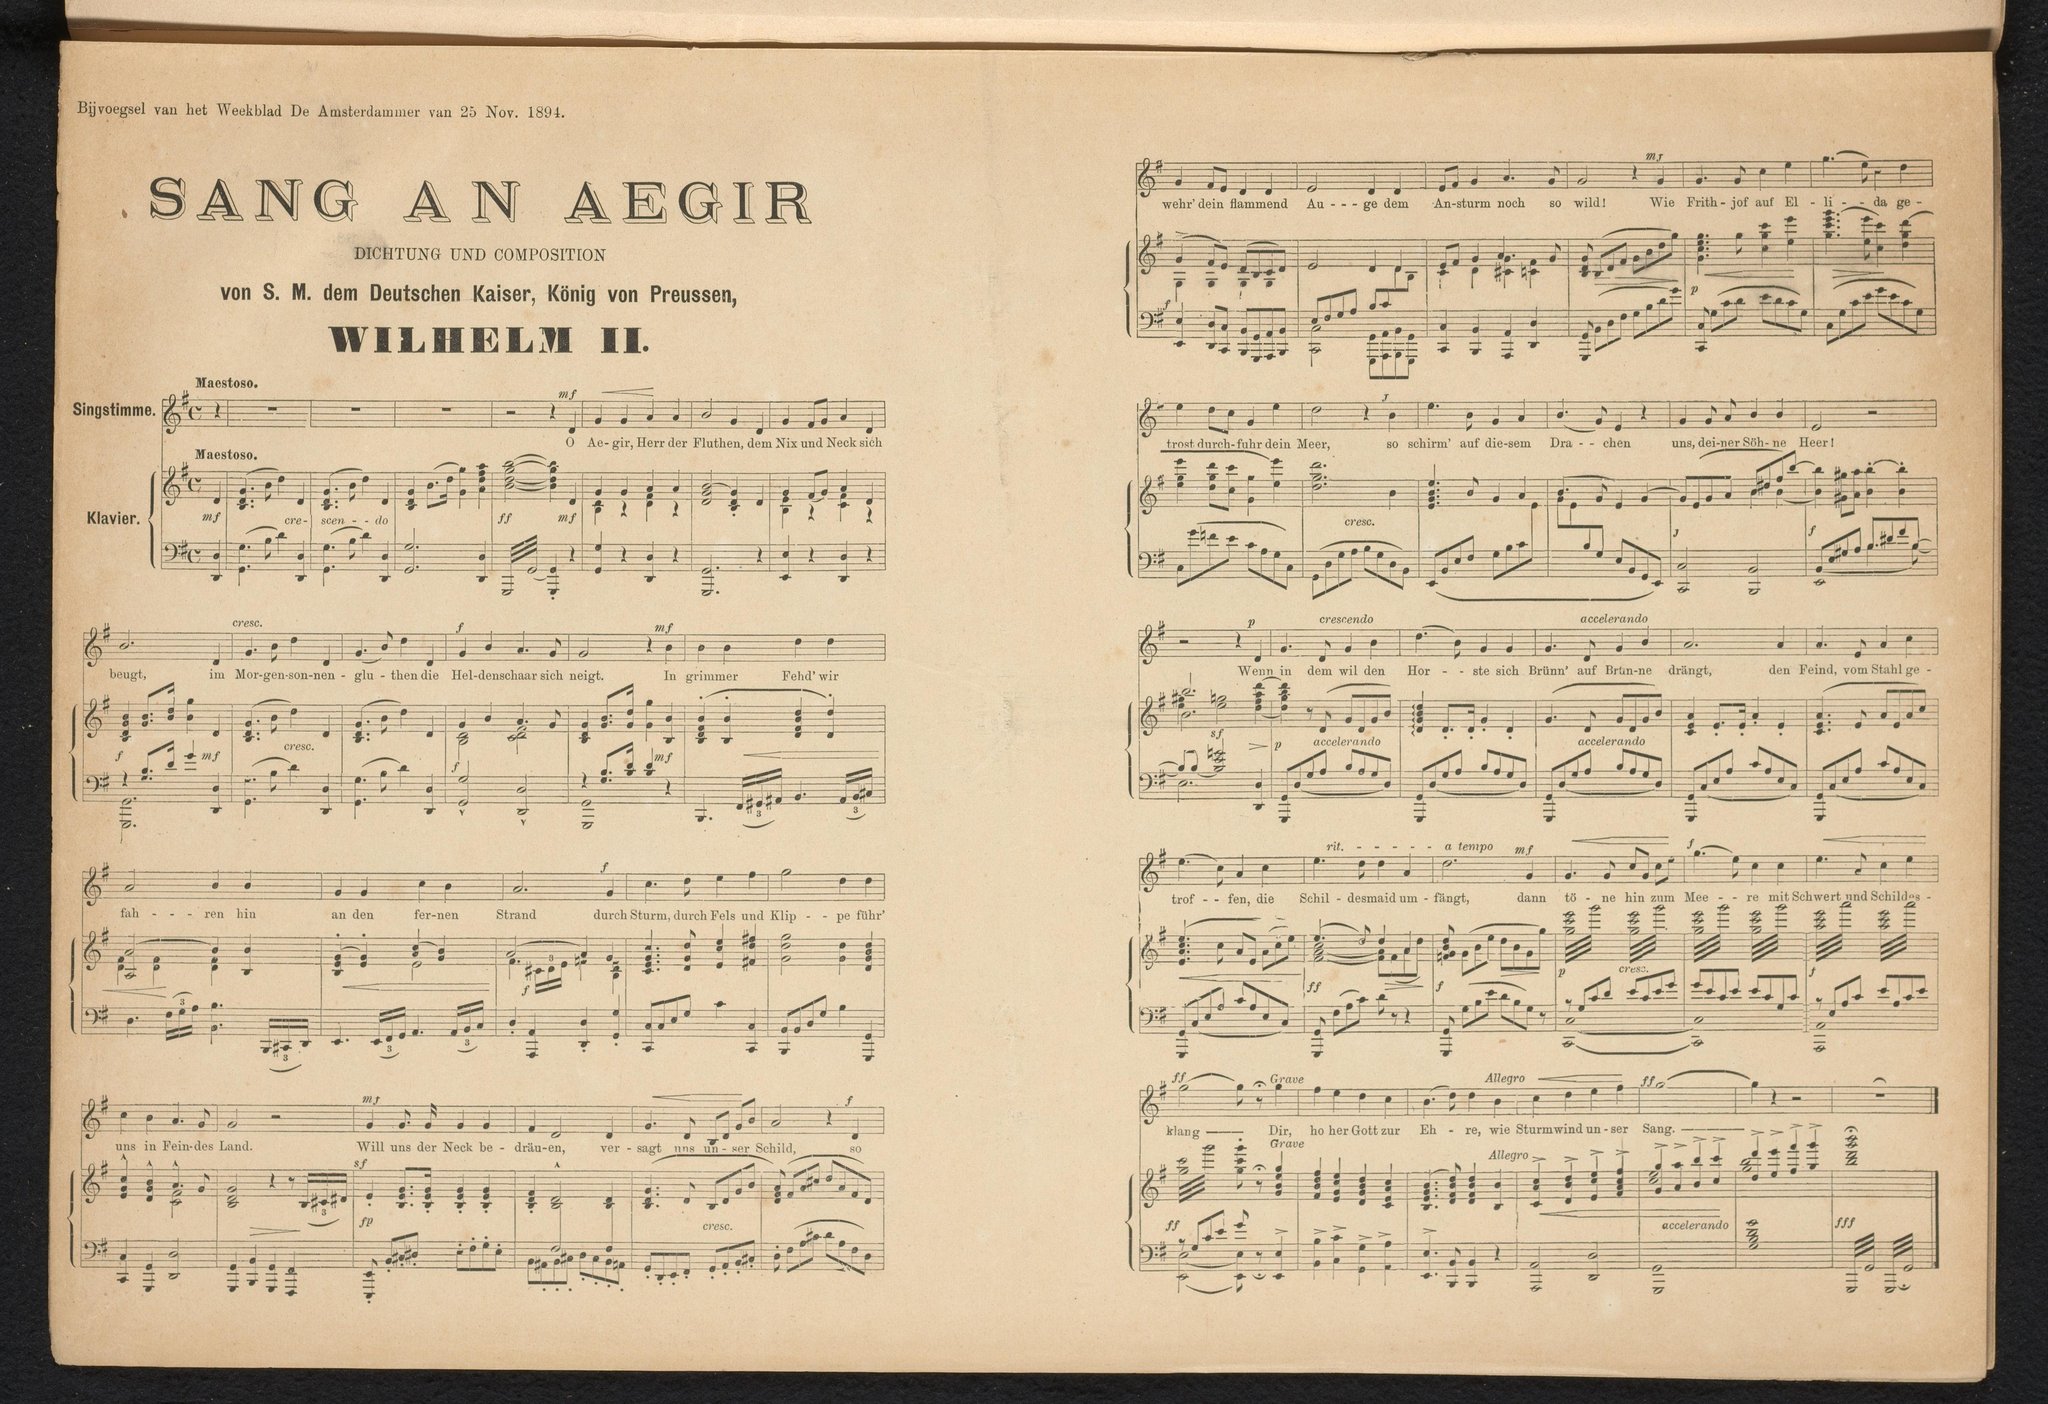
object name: sheet music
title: Sang an Aegir / Dichtung und Composition von S.M. dem Deutschen Kaiser (...) Wilhelm II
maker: wilhelm ii (keizer van duitsland)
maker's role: keizer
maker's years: 1859-1941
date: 1894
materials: paper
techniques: lithograph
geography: amsterdam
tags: printed edition of musical score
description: Muziek en woorden van het lied 'Sang an Aegir' gecomponeerd door de Duitse keizer Wilhelm II.